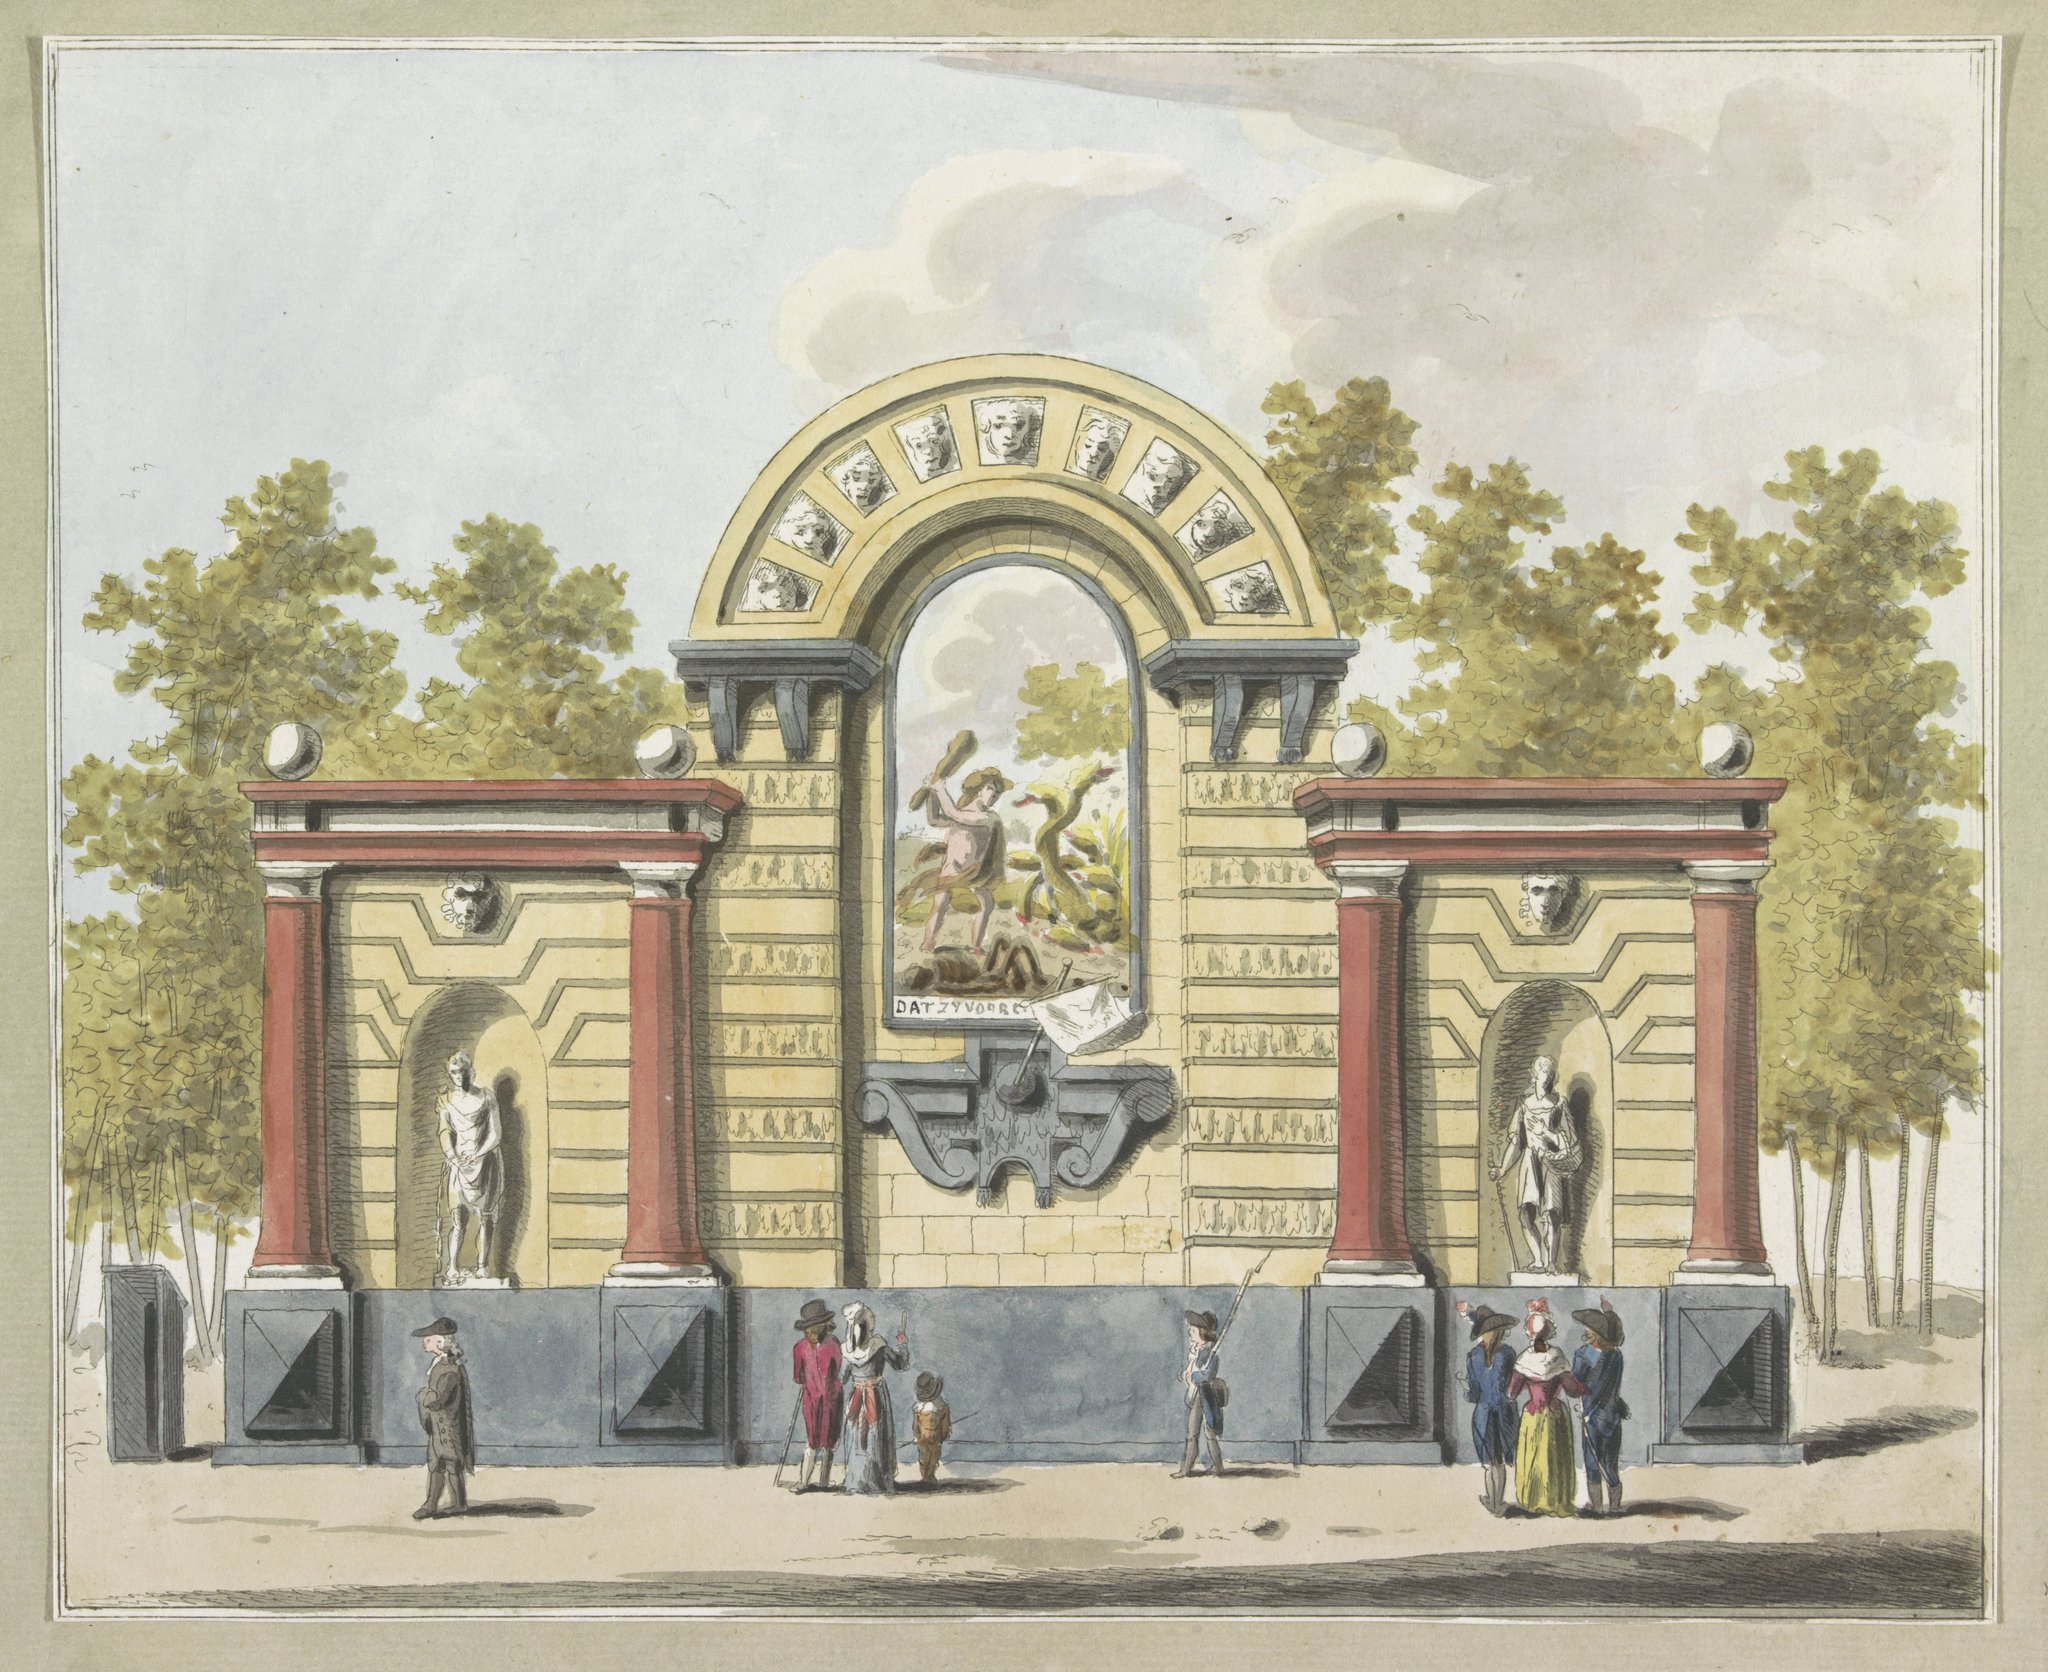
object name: print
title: Vernietiging der Aristocratie, decoratie op de Westermarkt, 1795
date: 1795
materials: paper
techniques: etching, hand coloring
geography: netherlands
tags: (2) the hydra of lerna is killed by hercules, festivities on events of national importance (+ festive decoration ~ festive activities), amsterdam, alliance with france (1785)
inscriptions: collector's mark: Lugt 2228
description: De Vernietiging der Aristocratie, allegorische decoratie opgericht op de Westermarkt te Amsterdam bij het Alliantiefeest op 19 juni 1795. Hercules (het Nederlandse volk) verslaat de zevenkoppige hydra (aristocratie en familieregering). Onderdeel van een serie van tien platen.